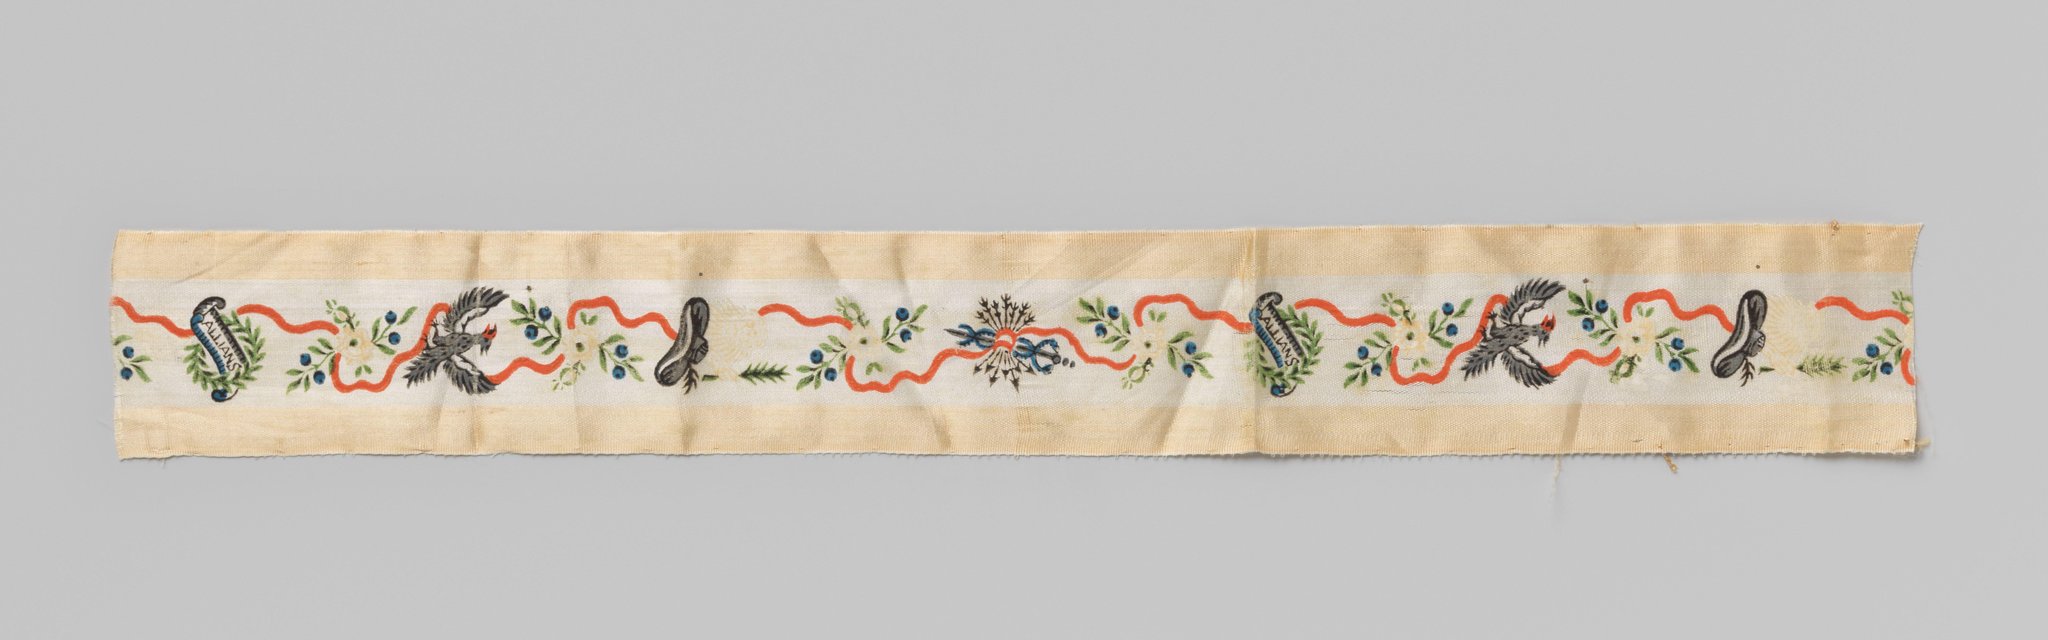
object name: ribbon material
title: Oranjelint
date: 1750-1775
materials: silk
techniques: printing, weave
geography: netherlands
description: Lint waarop een zestal versieringen die, tesamen met takjes oranje-appelen, zijn verbonden met een slingerend lint. Van boven naar beneden: - hoed met brede rand en opgestoken tak - adelaar met gespreide vleugels - banderolle met opschrift (lauwerkrans daaromheen) - ornament met zeven pijlen - hoed - adelaar - banderolle. Opschrift op banderolle: ALLIANS.